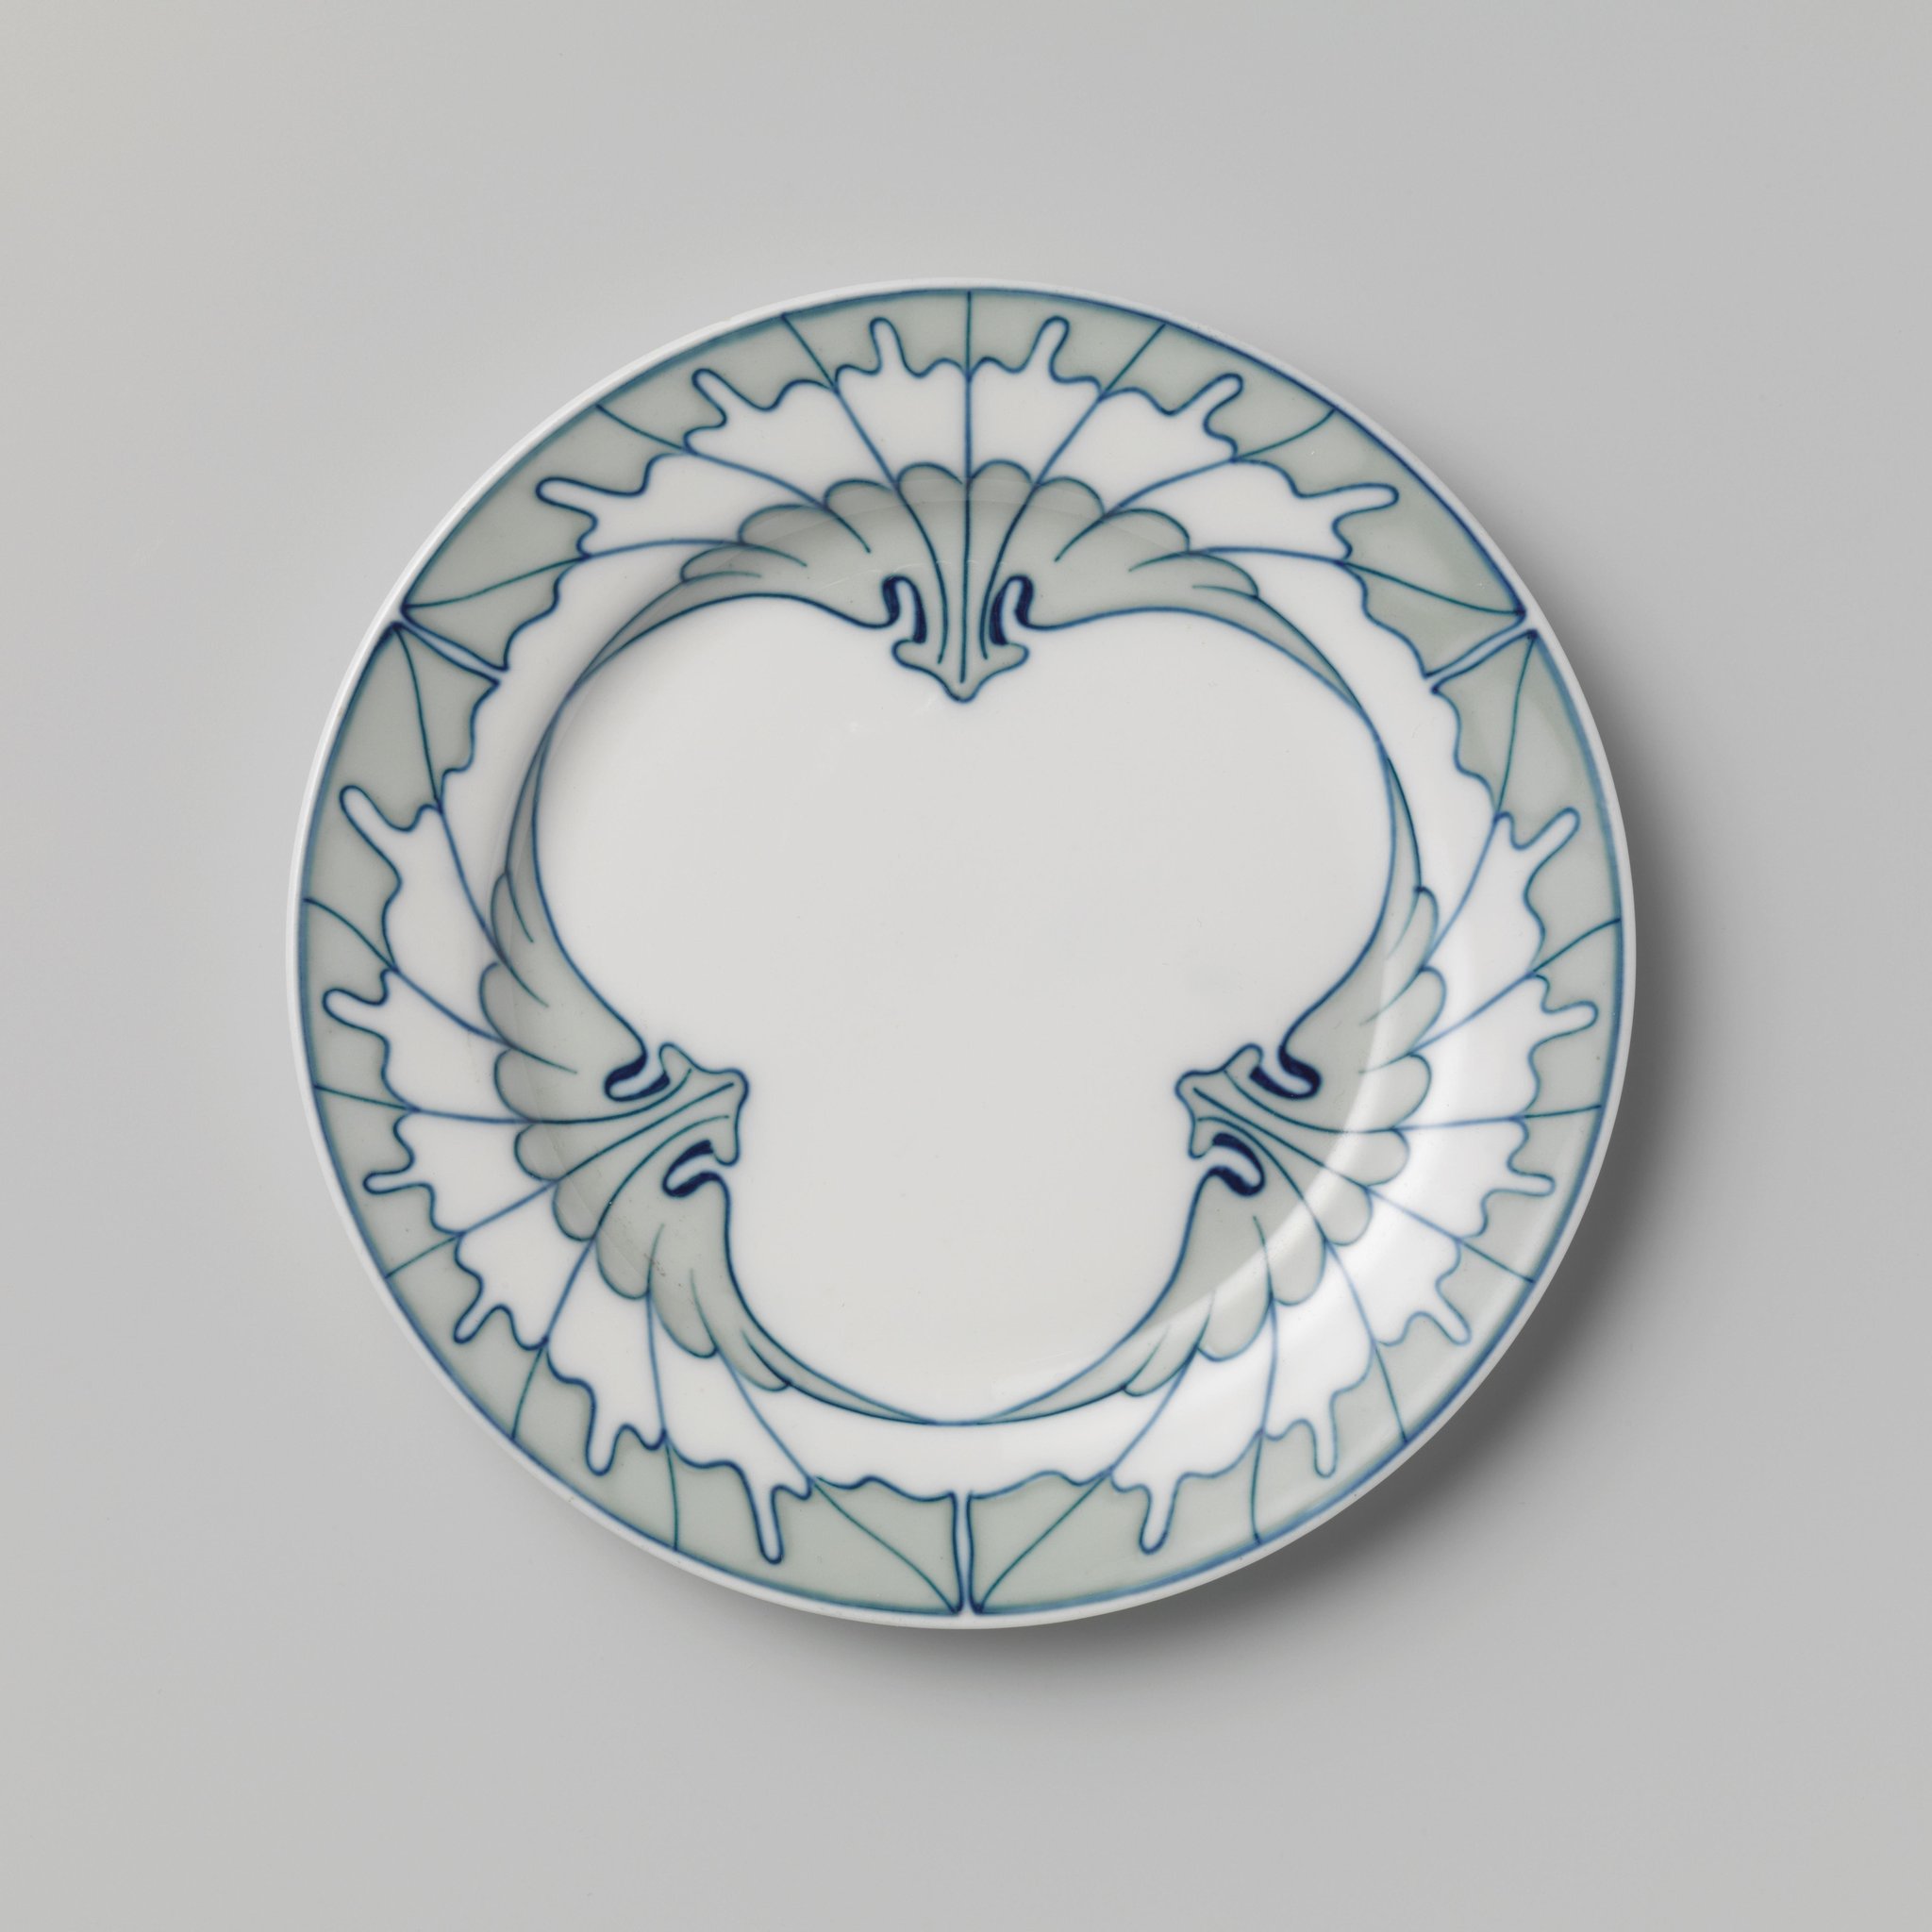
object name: plate dish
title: Bord, beschilderd met het Flügelmuster-decor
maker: konrad hentschel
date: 1901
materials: porcelain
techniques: painted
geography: meissen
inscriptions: factory mark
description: Bord van beschilderd porselein. Het bord is beschilderd in groen en blauw met het Flügelmuster. Het bord hoort bij een servies (BK-1976-65-1 t/m BK-1976-65-34) en is gemerkt.